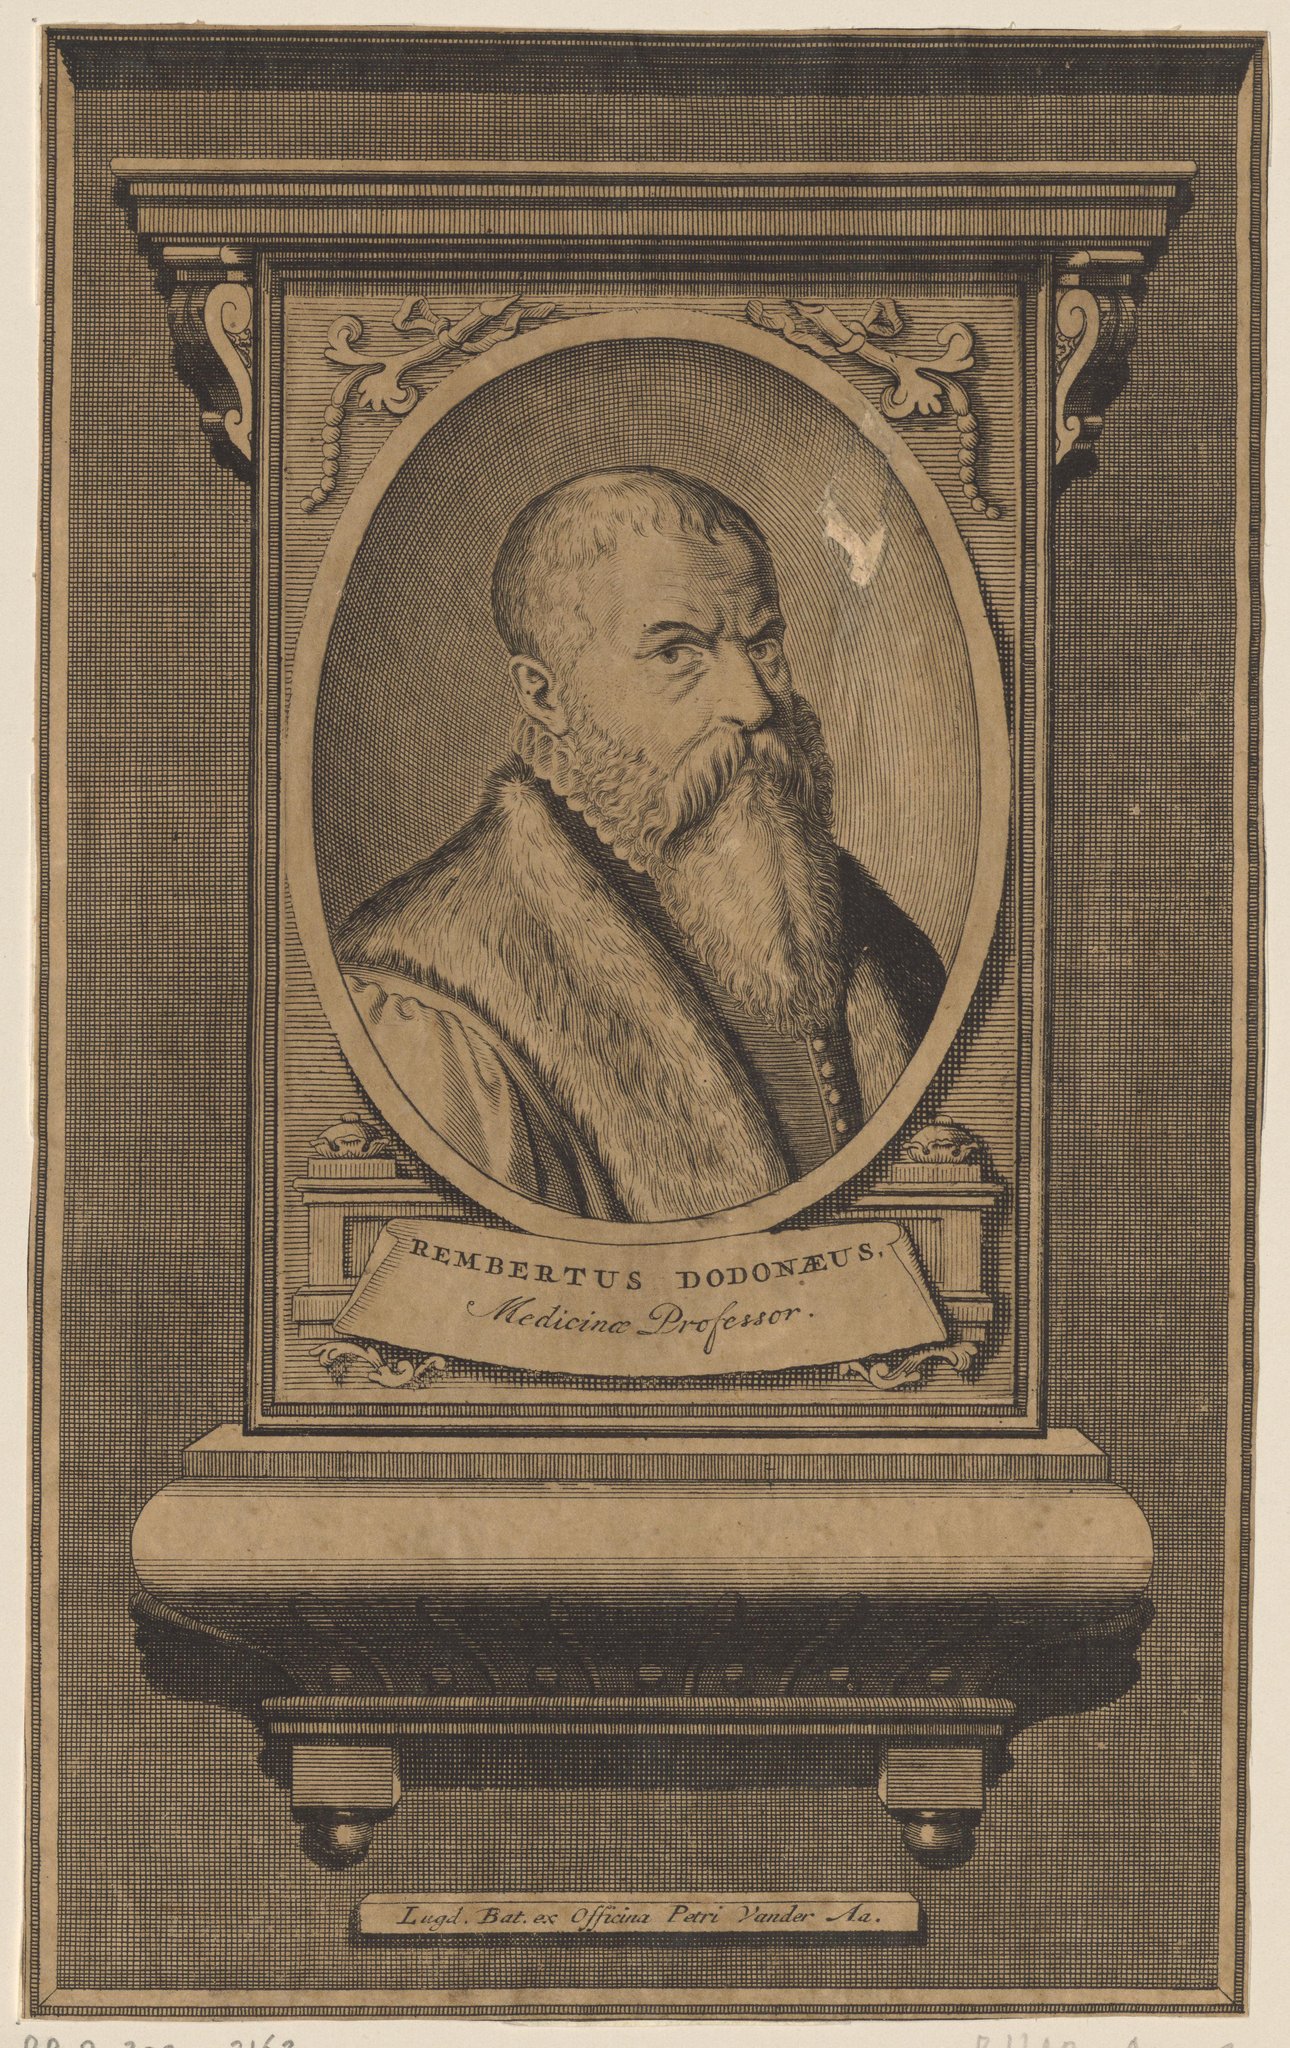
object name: print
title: Portret van Rembertus Dodonaeus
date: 1716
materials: paper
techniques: engraving, etching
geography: leiden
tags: mechelen, leiden, rembertus dodonaeus, historical persons, physician, doctor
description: Prent mogelijk uit: Fundatoris curatorum et professorum celeberrimorum, (...) academia Lugduno-Batava (...). Leiden: Pieter van der Aa, [ca. 1716]. Prent ook gebruikt in eerdere en latere publicaties.